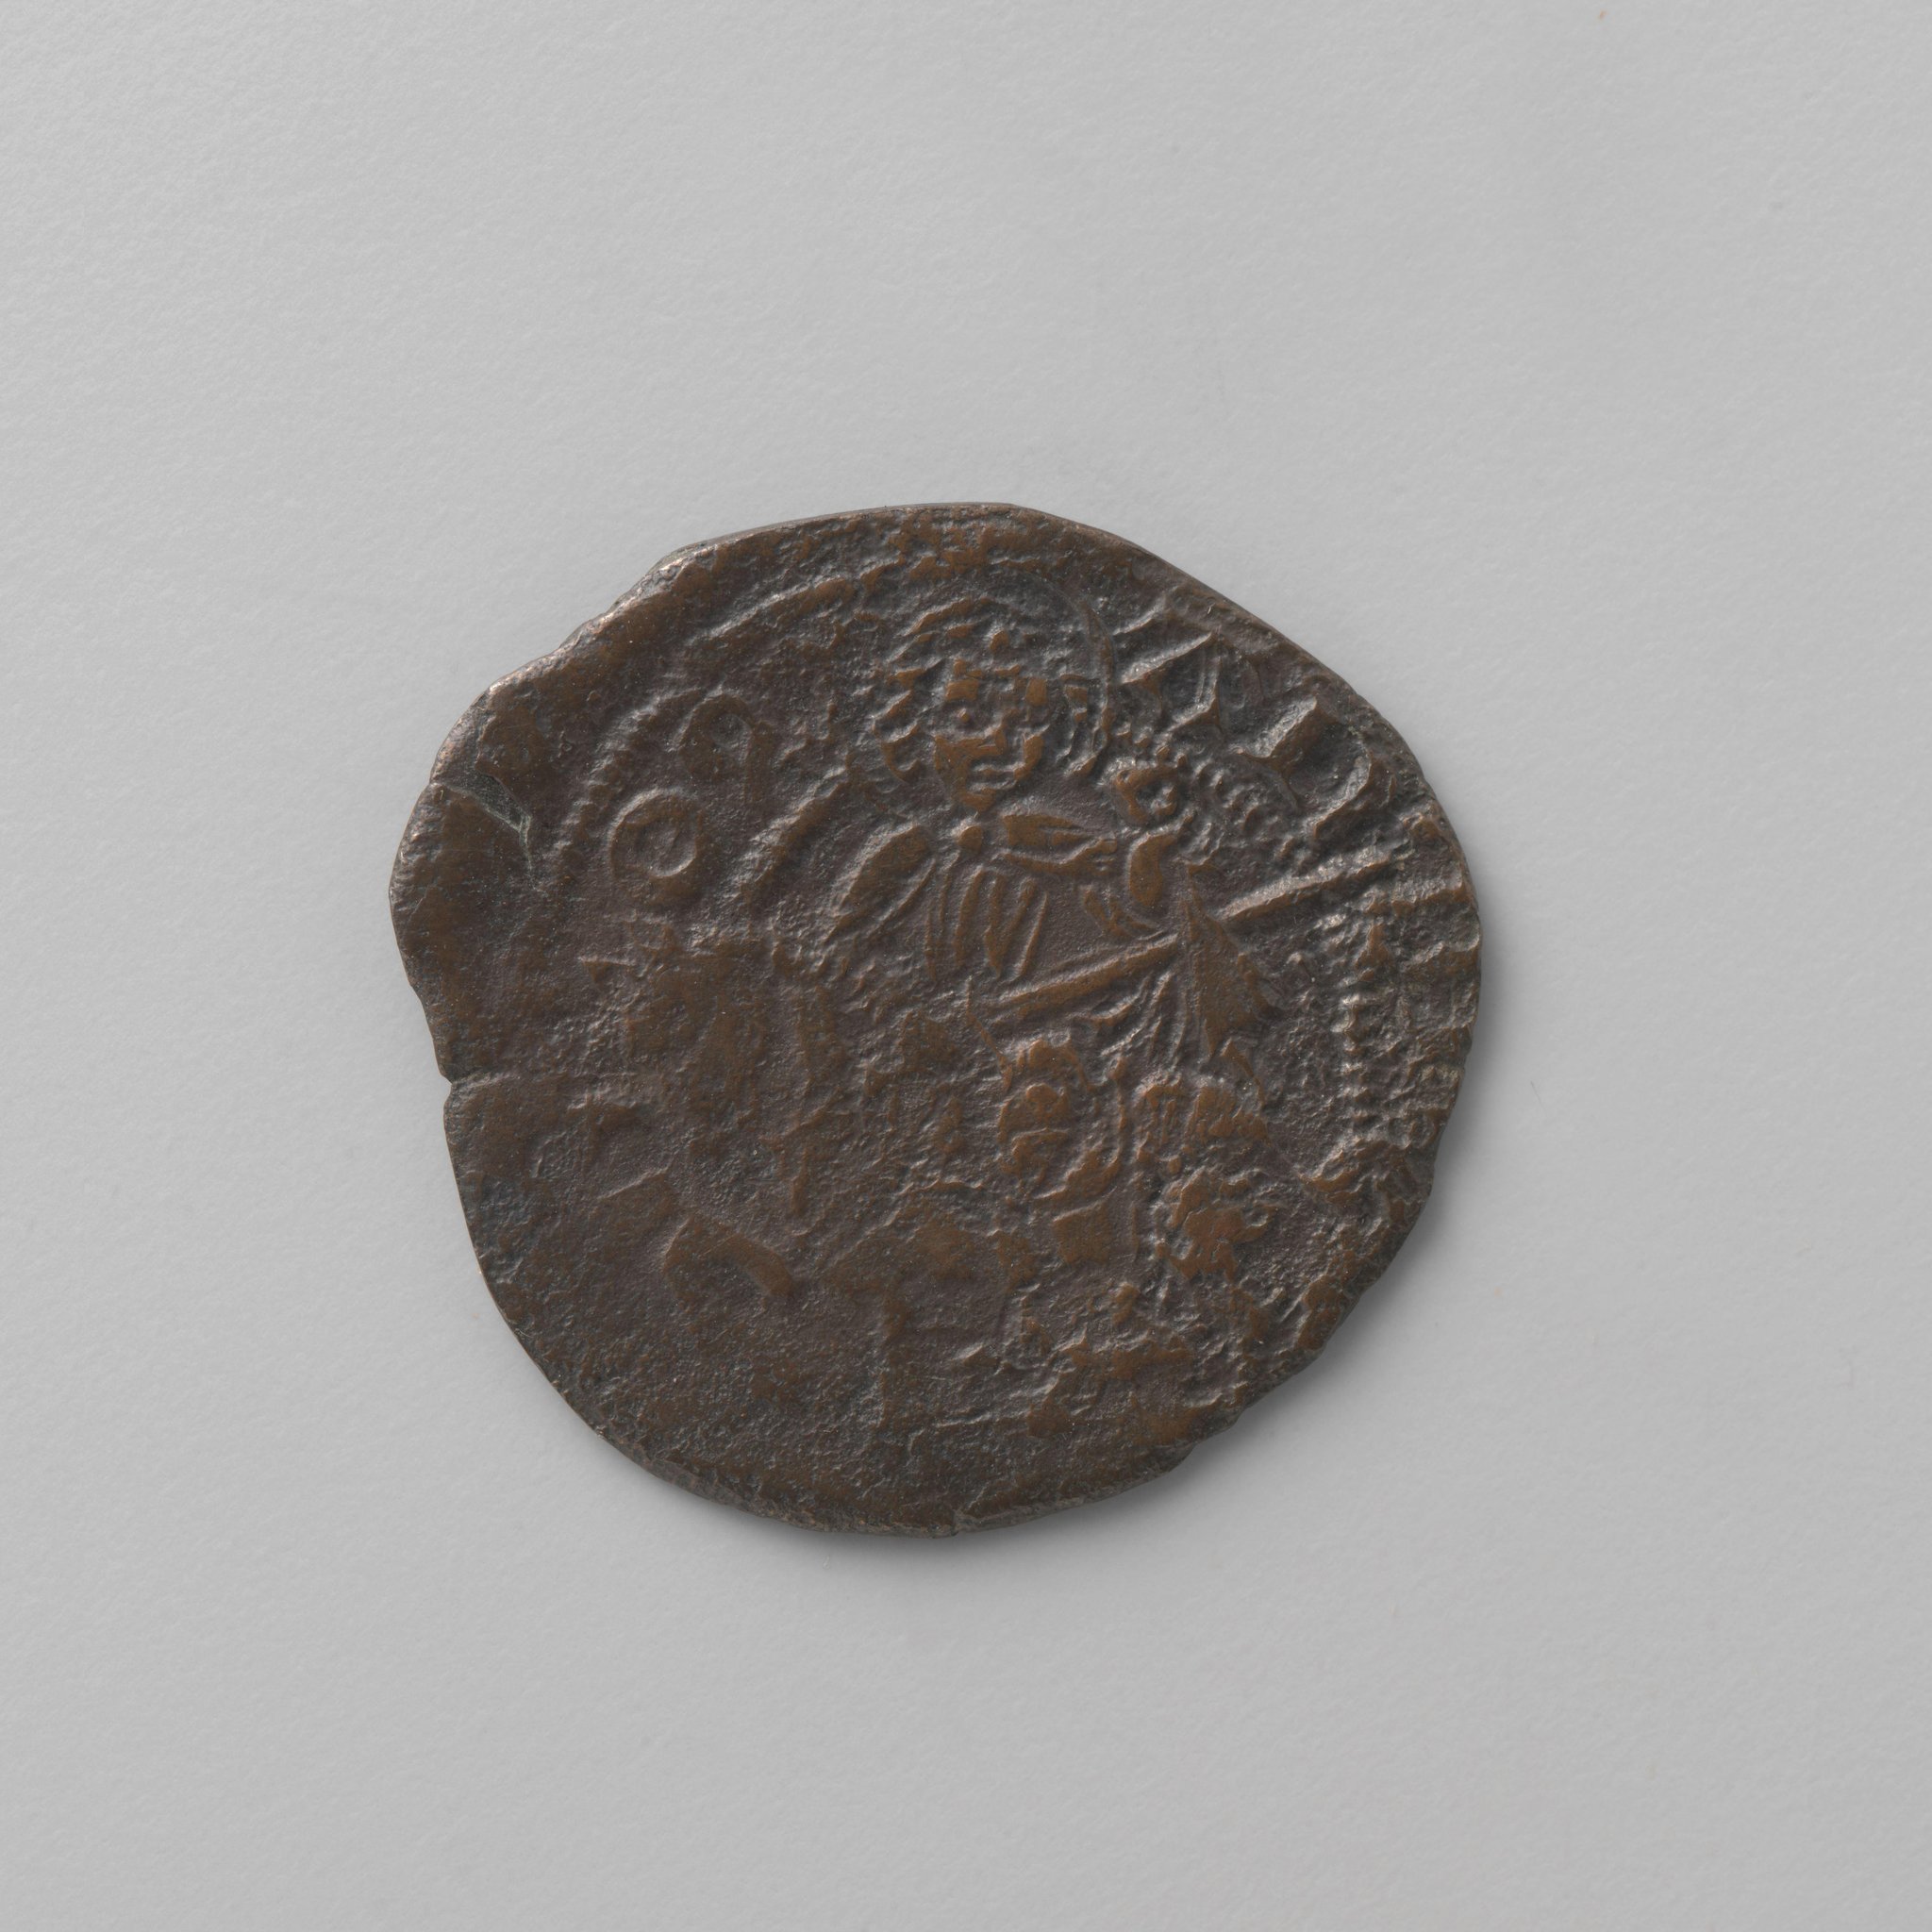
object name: coin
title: Duit van de stad Utrecht, 1509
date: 1509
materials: copper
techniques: striking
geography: utrecht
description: Koperen munt. Voorzijde: gevleugelde engel, die wapenschild van de stad Utrecht vasthoudt. Keerzijde: heilige te paard naar links. In omschrift jaartal.